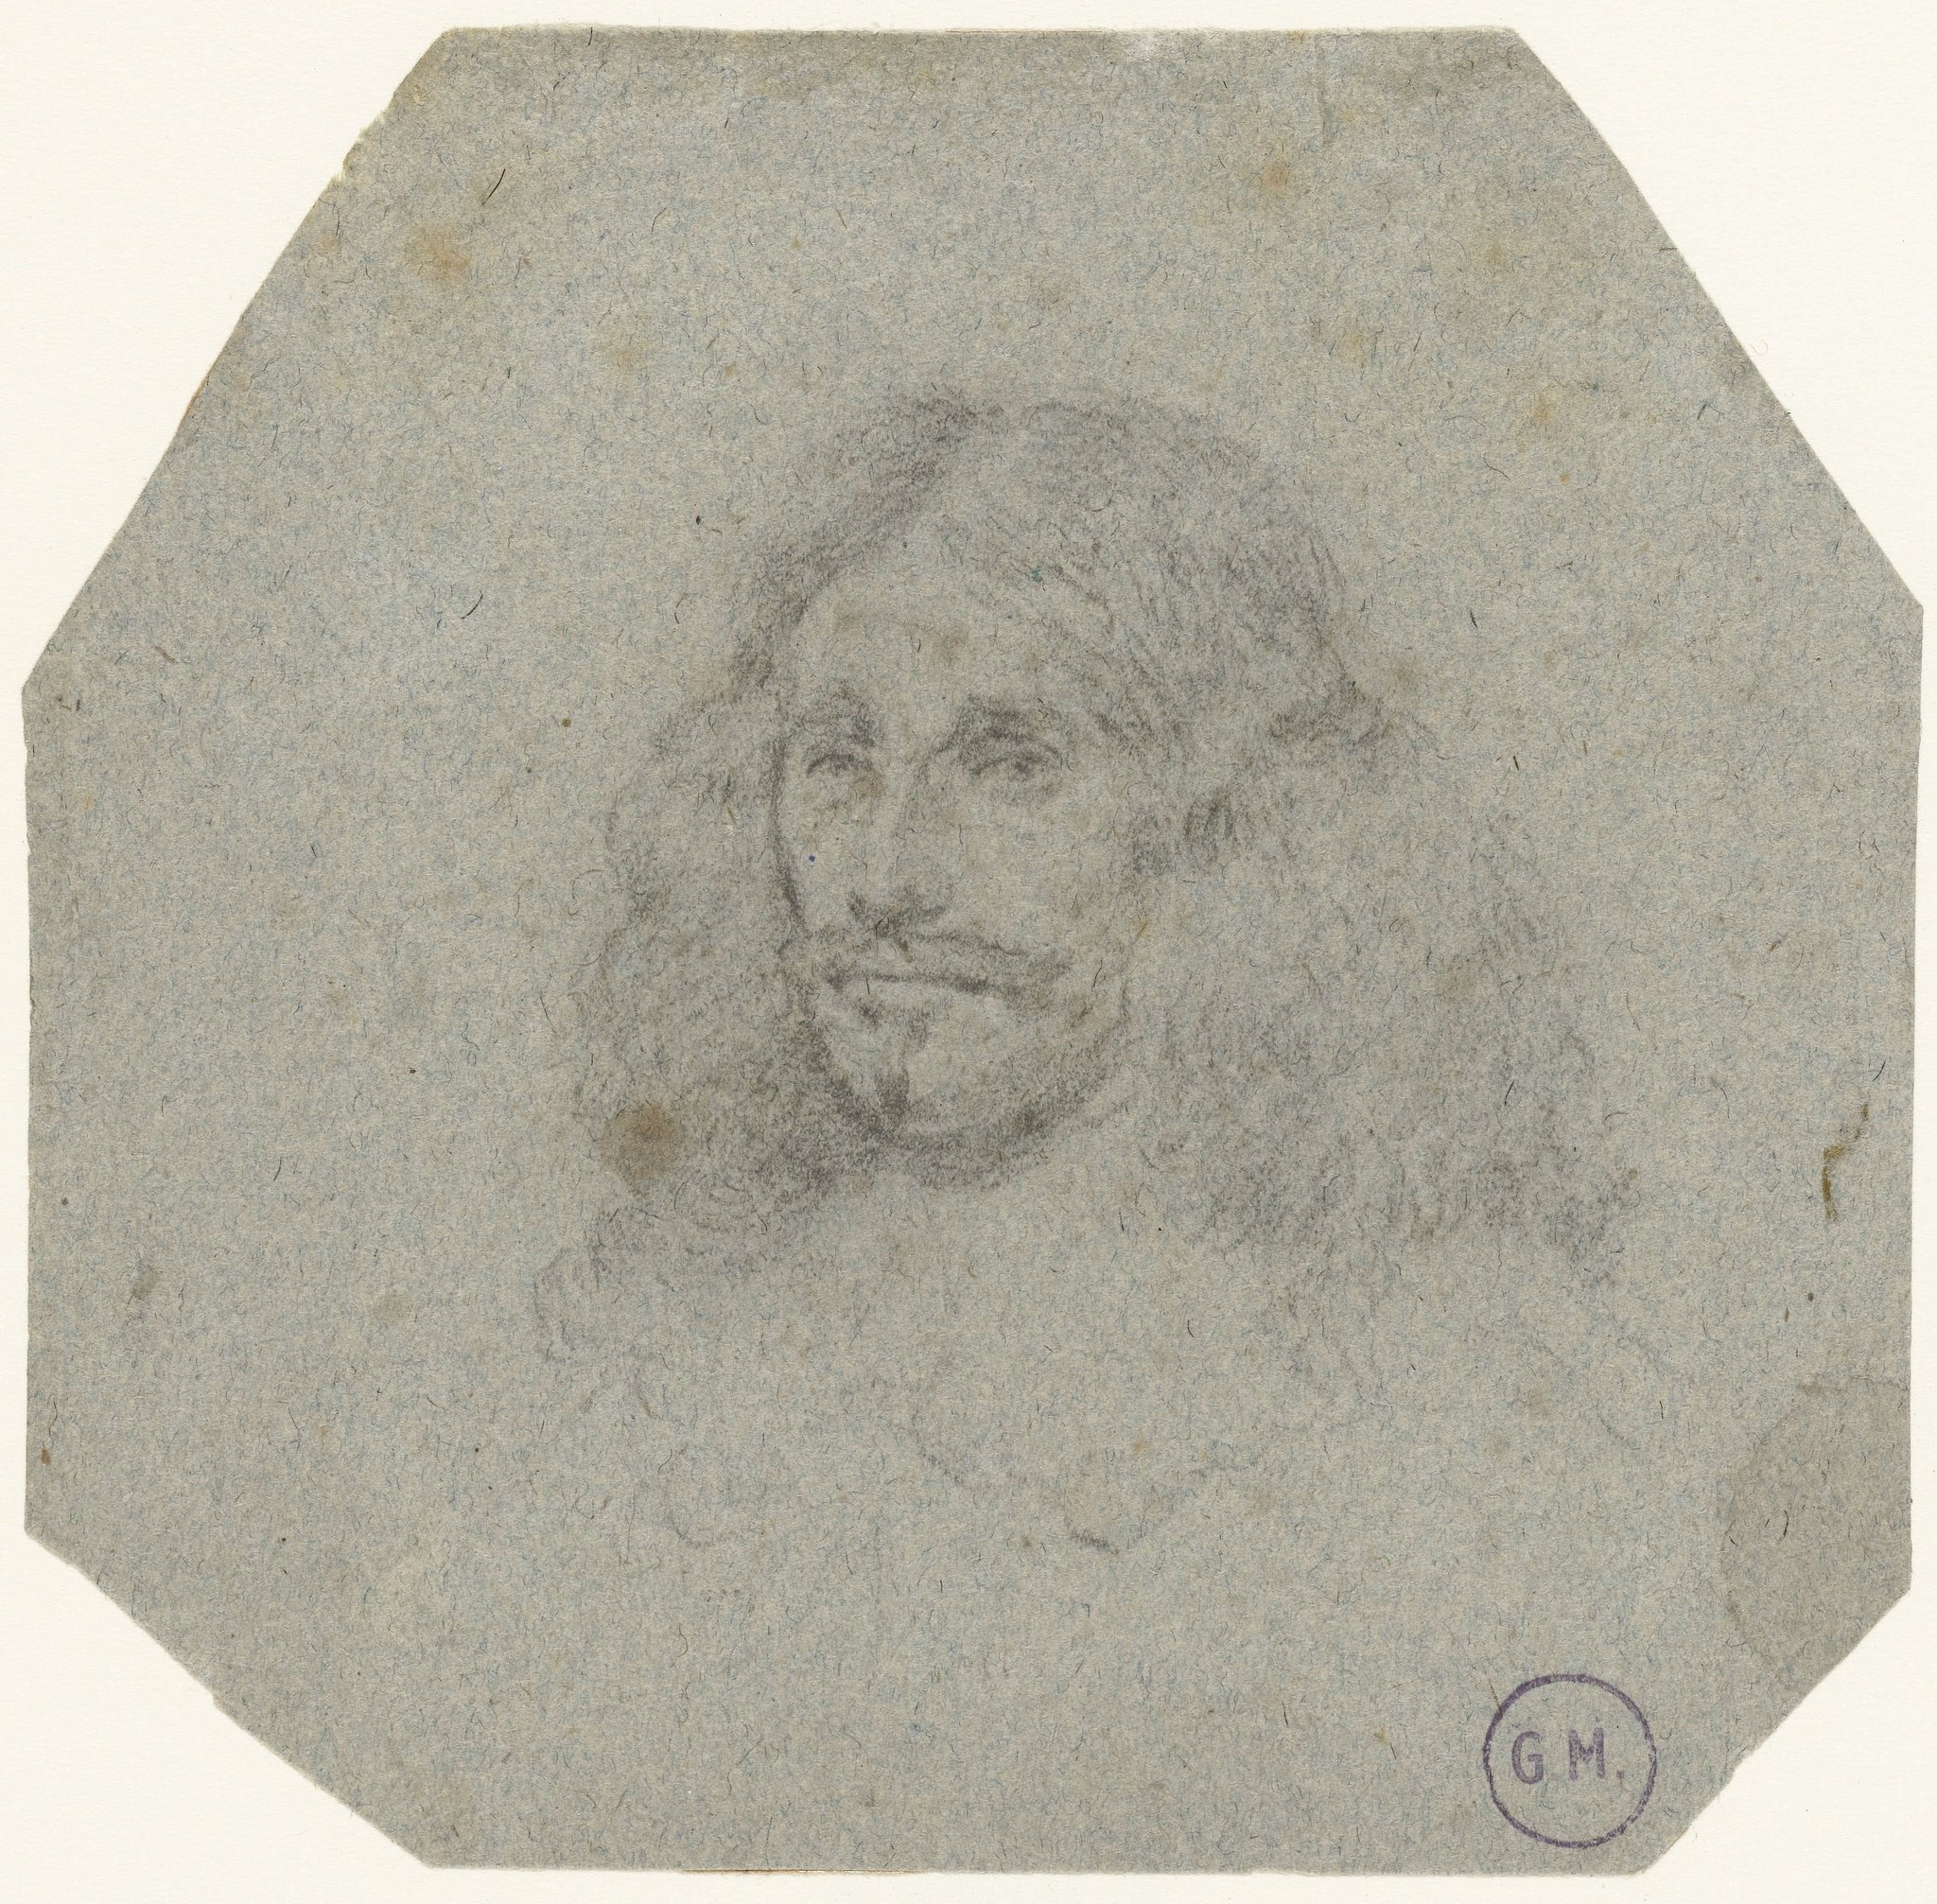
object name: drawing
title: Portetbuste van een (Spaanse?) heer, naar links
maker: gerard ter borch (ii)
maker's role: draughtsman, painter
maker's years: 1617-1681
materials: chalk, paper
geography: munster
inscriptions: collector's mark: ‘G.M.’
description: Vormt deel van een reeks miniatuurportretten uit een schetsboek, in zwart krijt op grijs papier, met afgeschuinde hoeken, door van Regteren Altena in 1972 gepubliceerd en door hem als Spaanse heren gekwalificeerd. Schetsboek is niet in de ateliernalatenschap teruggevonden.